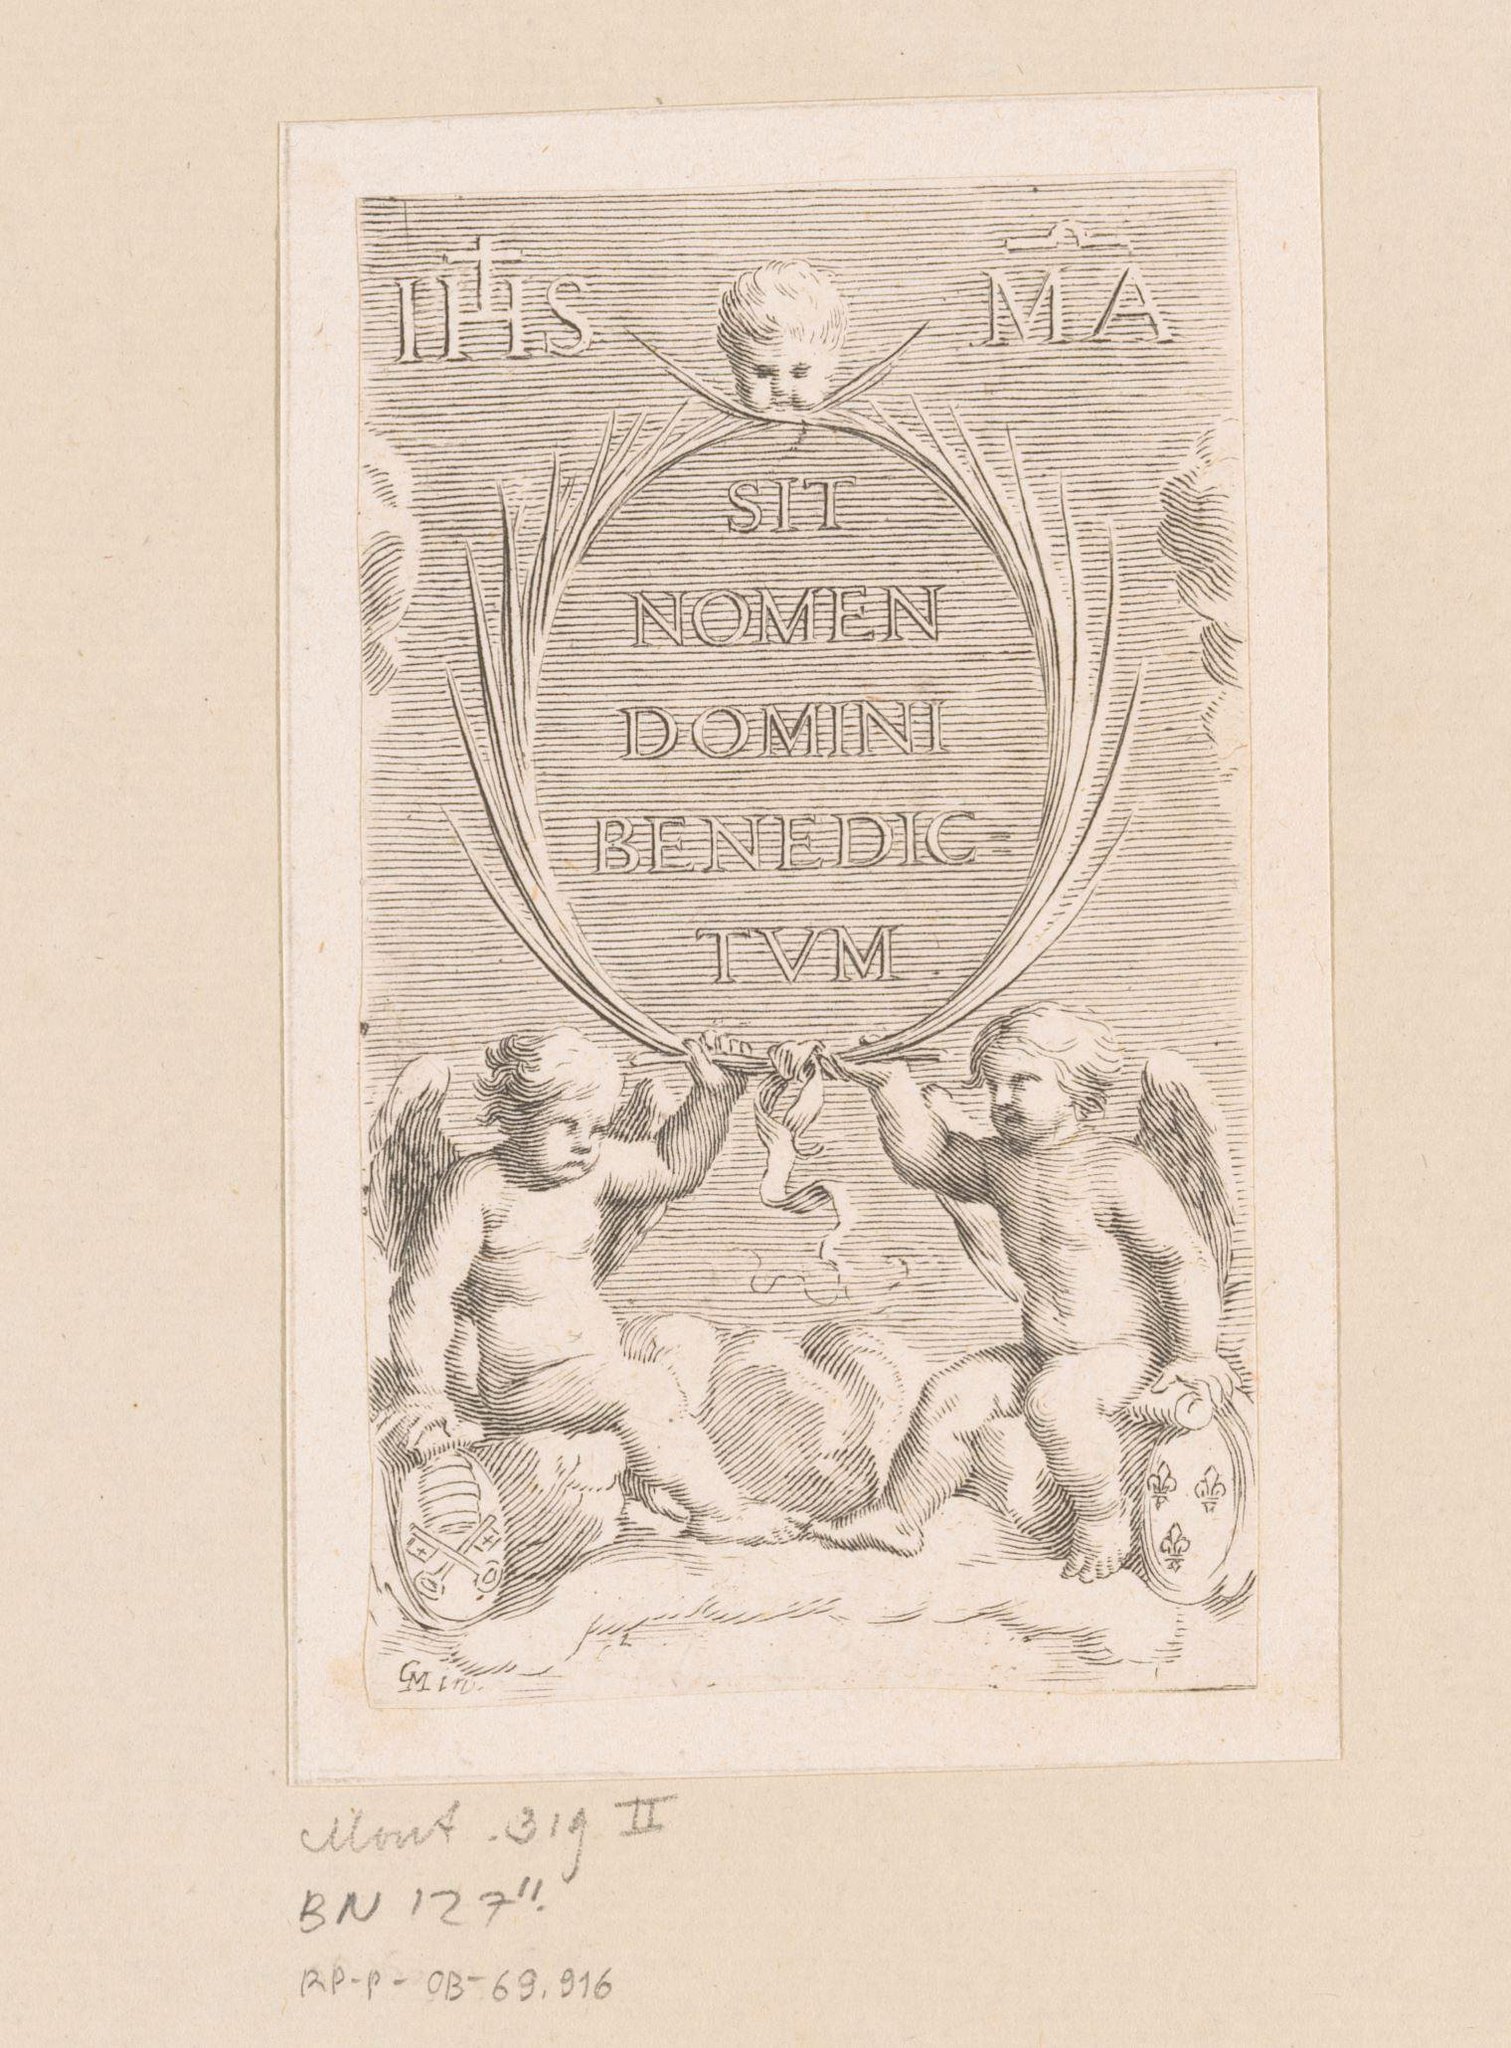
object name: print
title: Twee putti met medaillon van laurier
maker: claude mellan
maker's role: draughtsman, print maker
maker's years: 1598-1688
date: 1608-1688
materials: paper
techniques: engraving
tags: cupids: 'amores', 'amoretti', 'putti'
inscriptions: collector's mark: Lugt 240